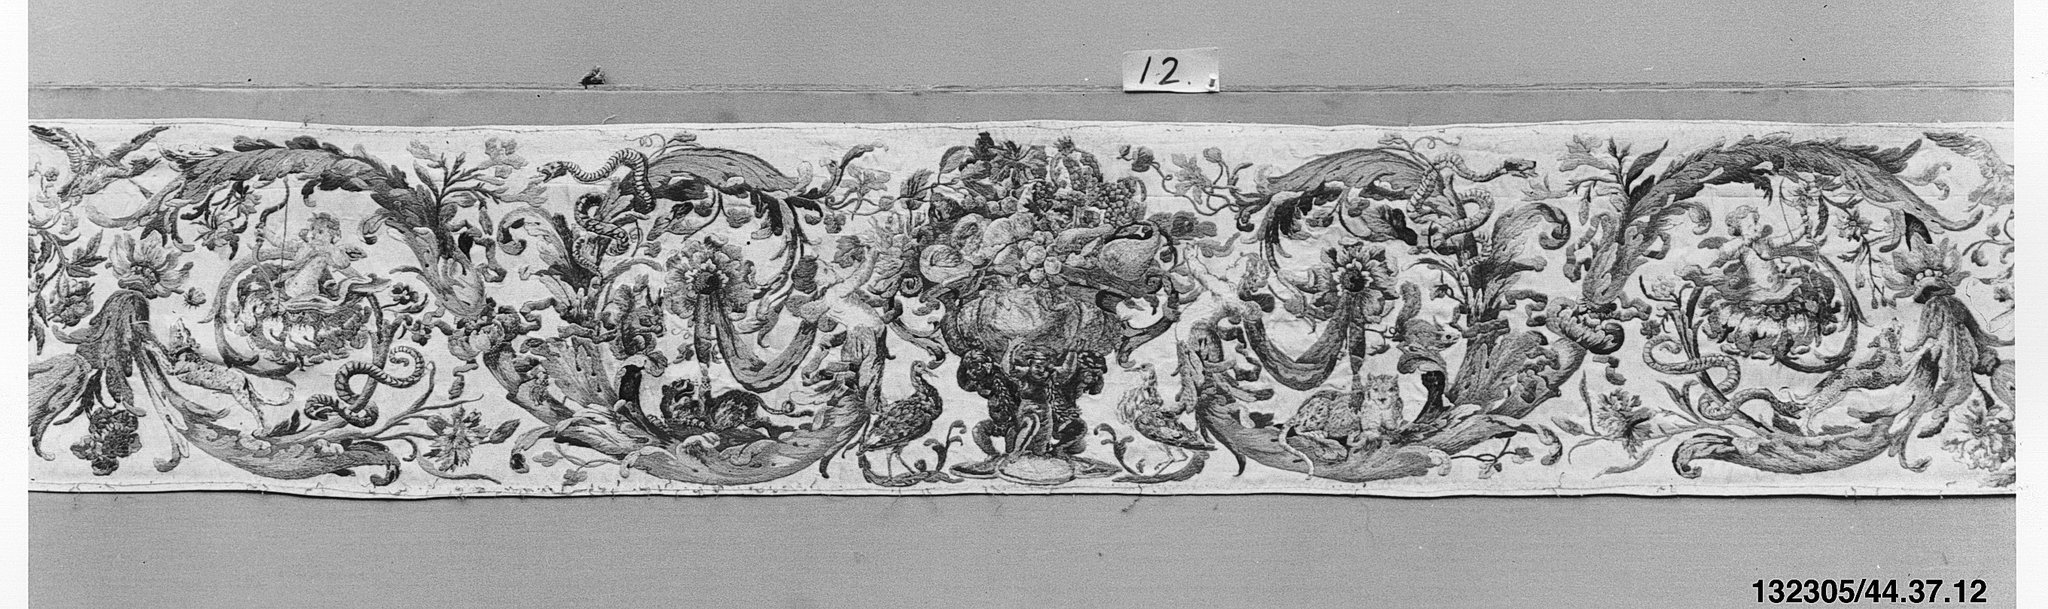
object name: valance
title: Valance (one of a set of six)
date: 1667-1733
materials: silk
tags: birds,flowers